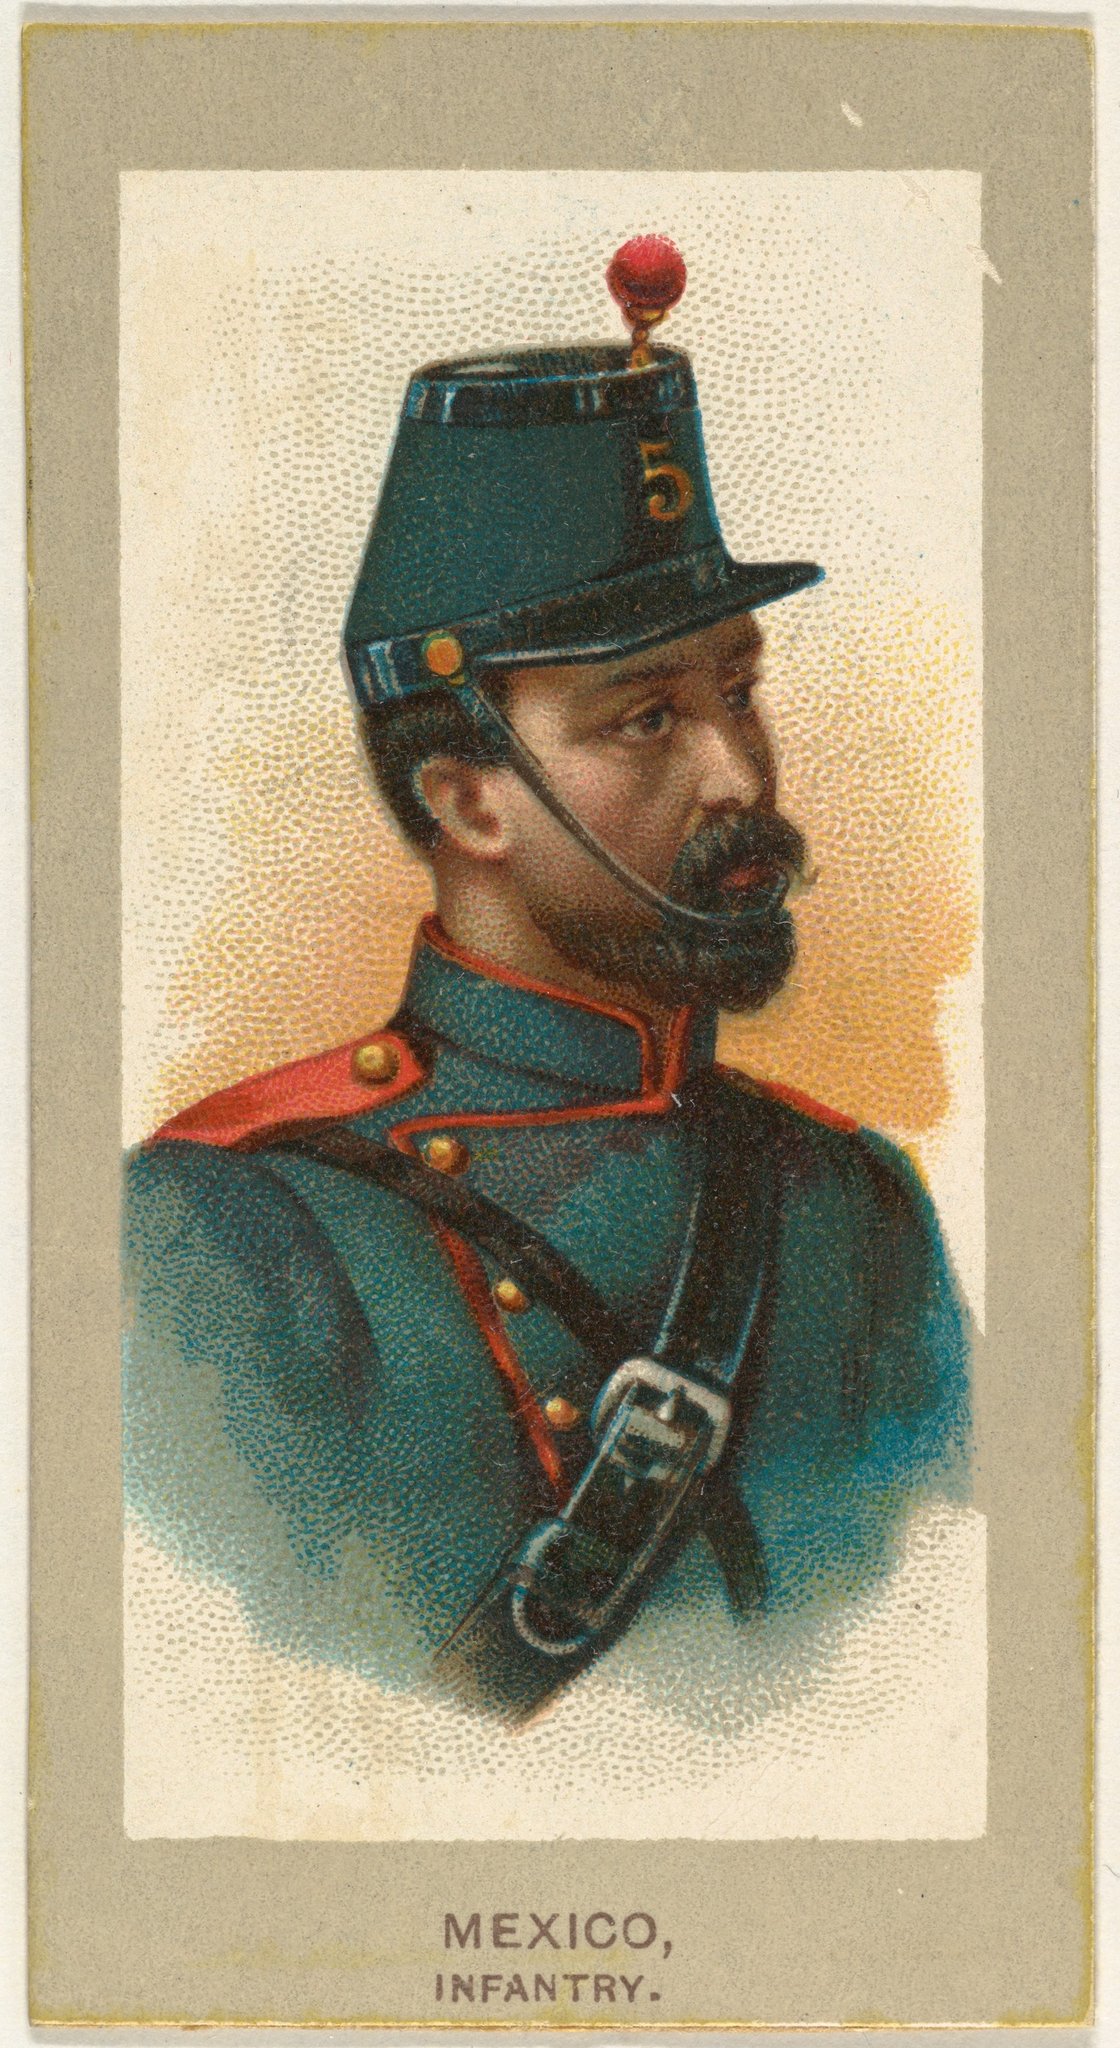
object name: print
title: Infantry, Mexico, from the Military Uniforms series (T182) issued by Abdul Cigarettes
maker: abdul cigarettes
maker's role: publisher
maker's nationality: american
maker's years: 1881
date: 1881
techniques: color lithograph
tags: soldiers